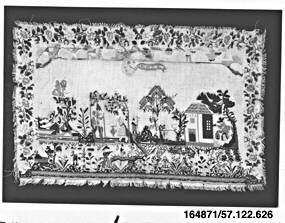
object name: sampler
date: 1854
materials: cotton, silk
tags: houses,trees